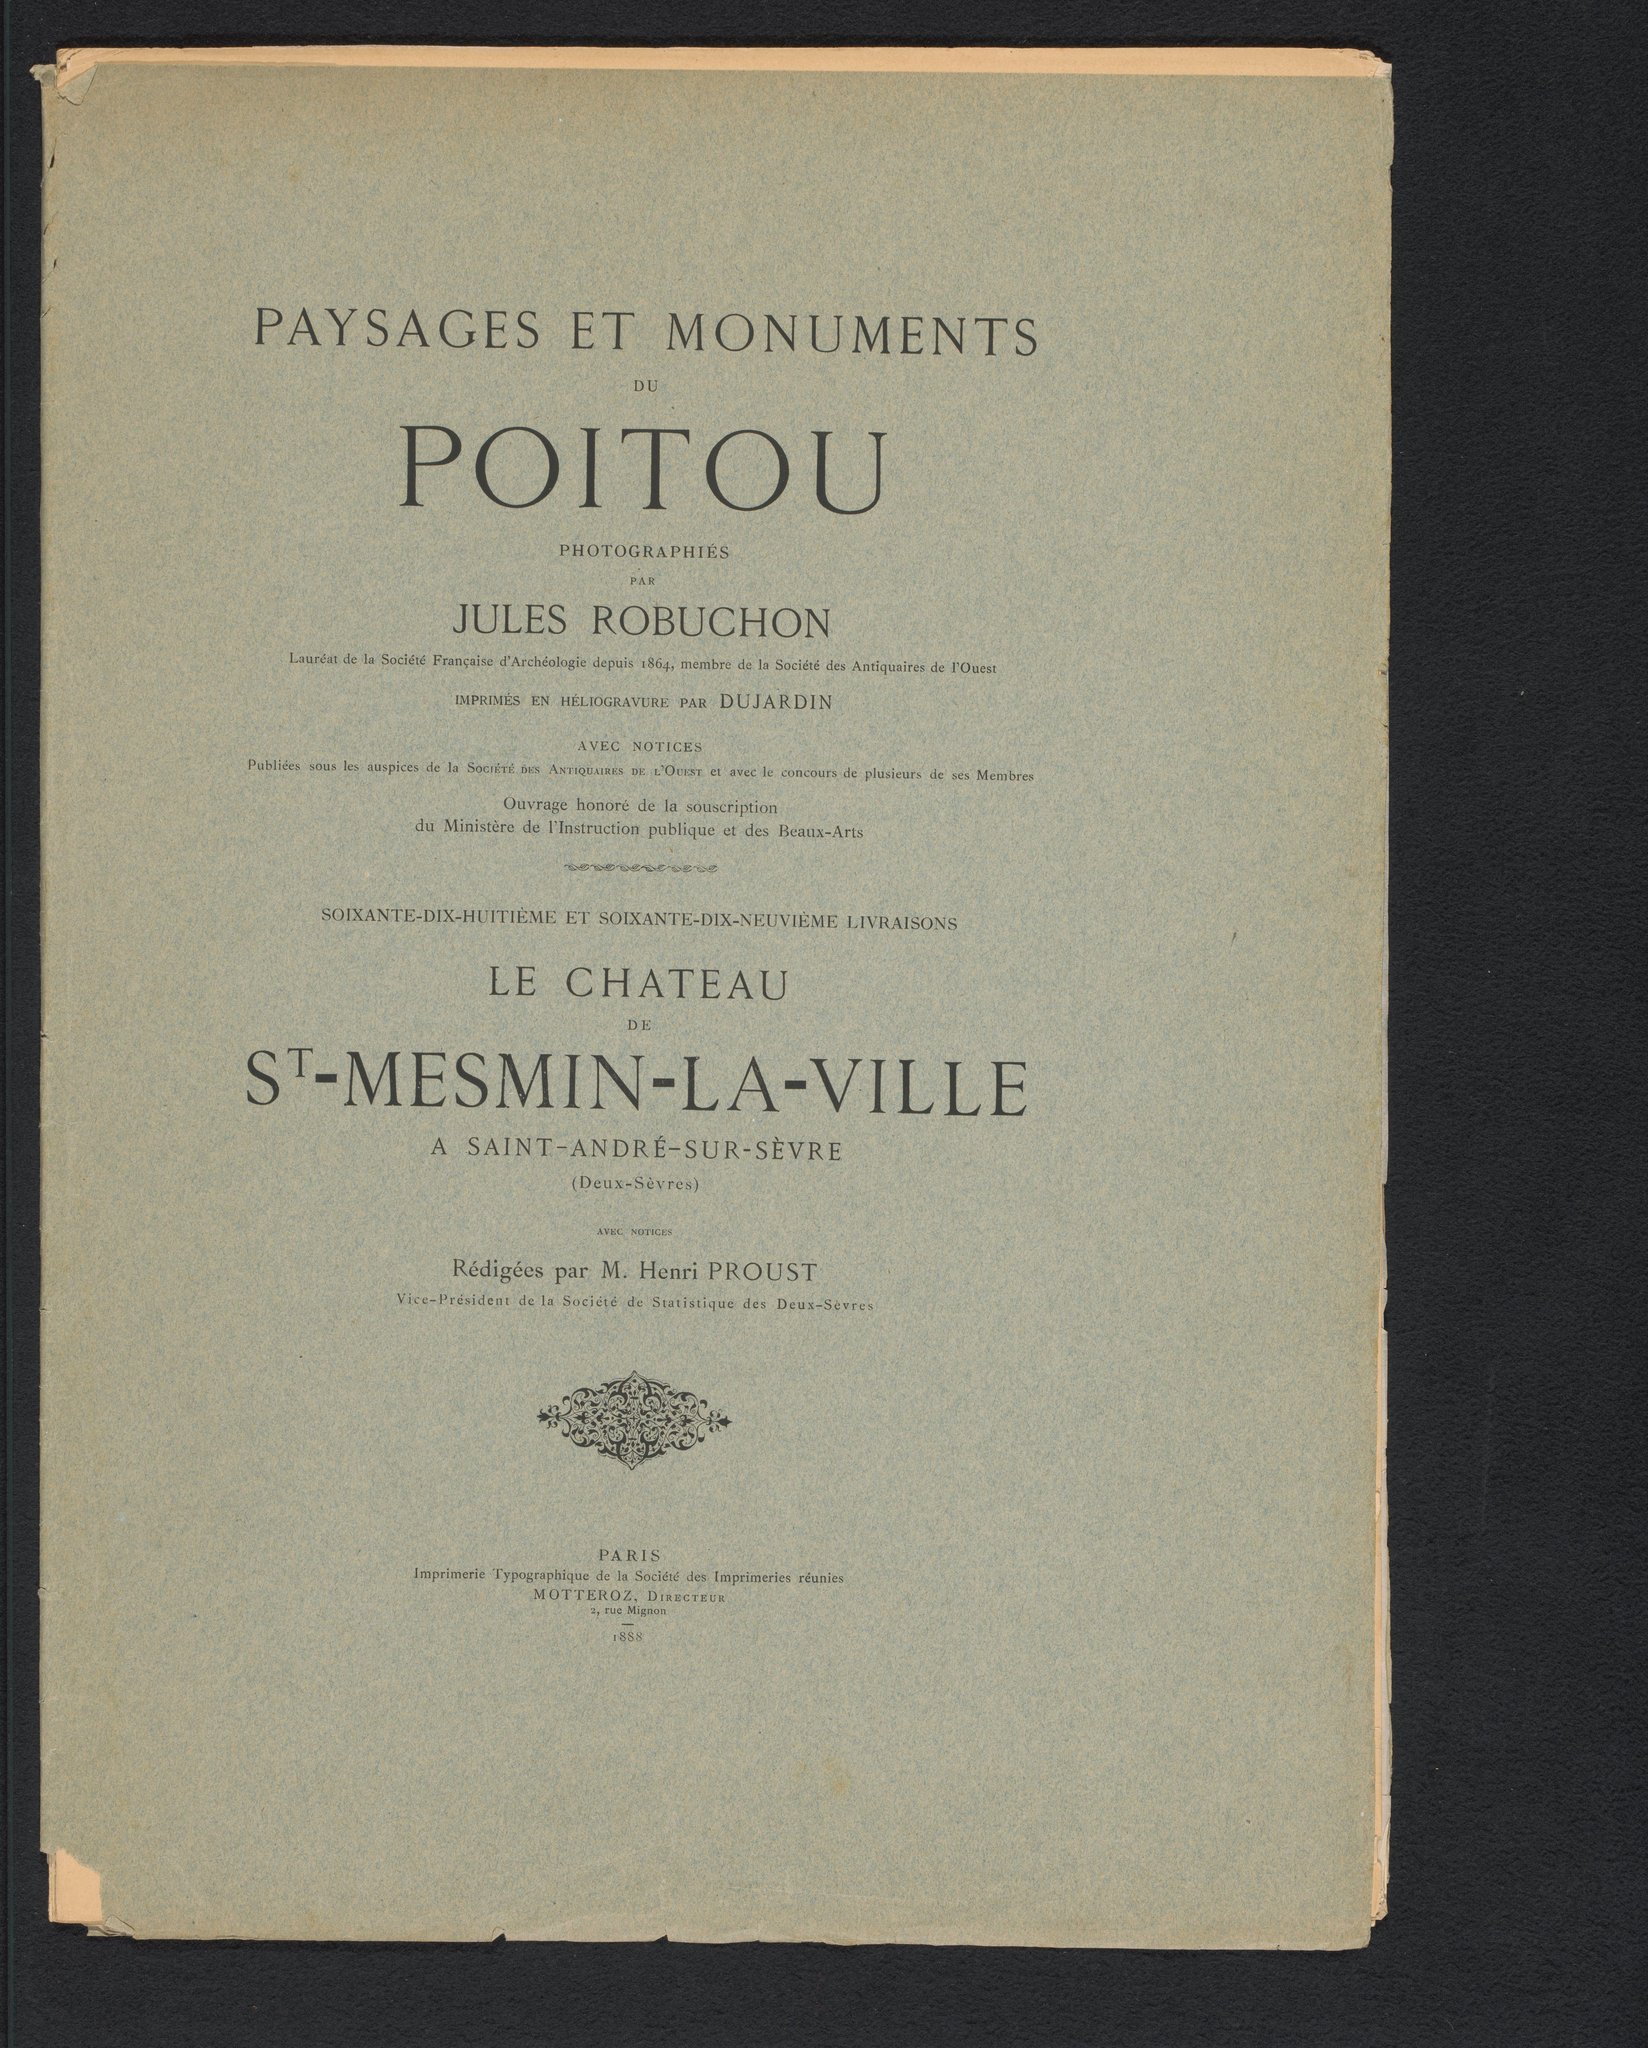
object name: book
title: Paysages et monuments du Poitou / photogr. par Jules Robuchon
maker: henri m. proust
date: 1888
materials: paper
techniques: photoaquatint, printing, engraving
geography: paris